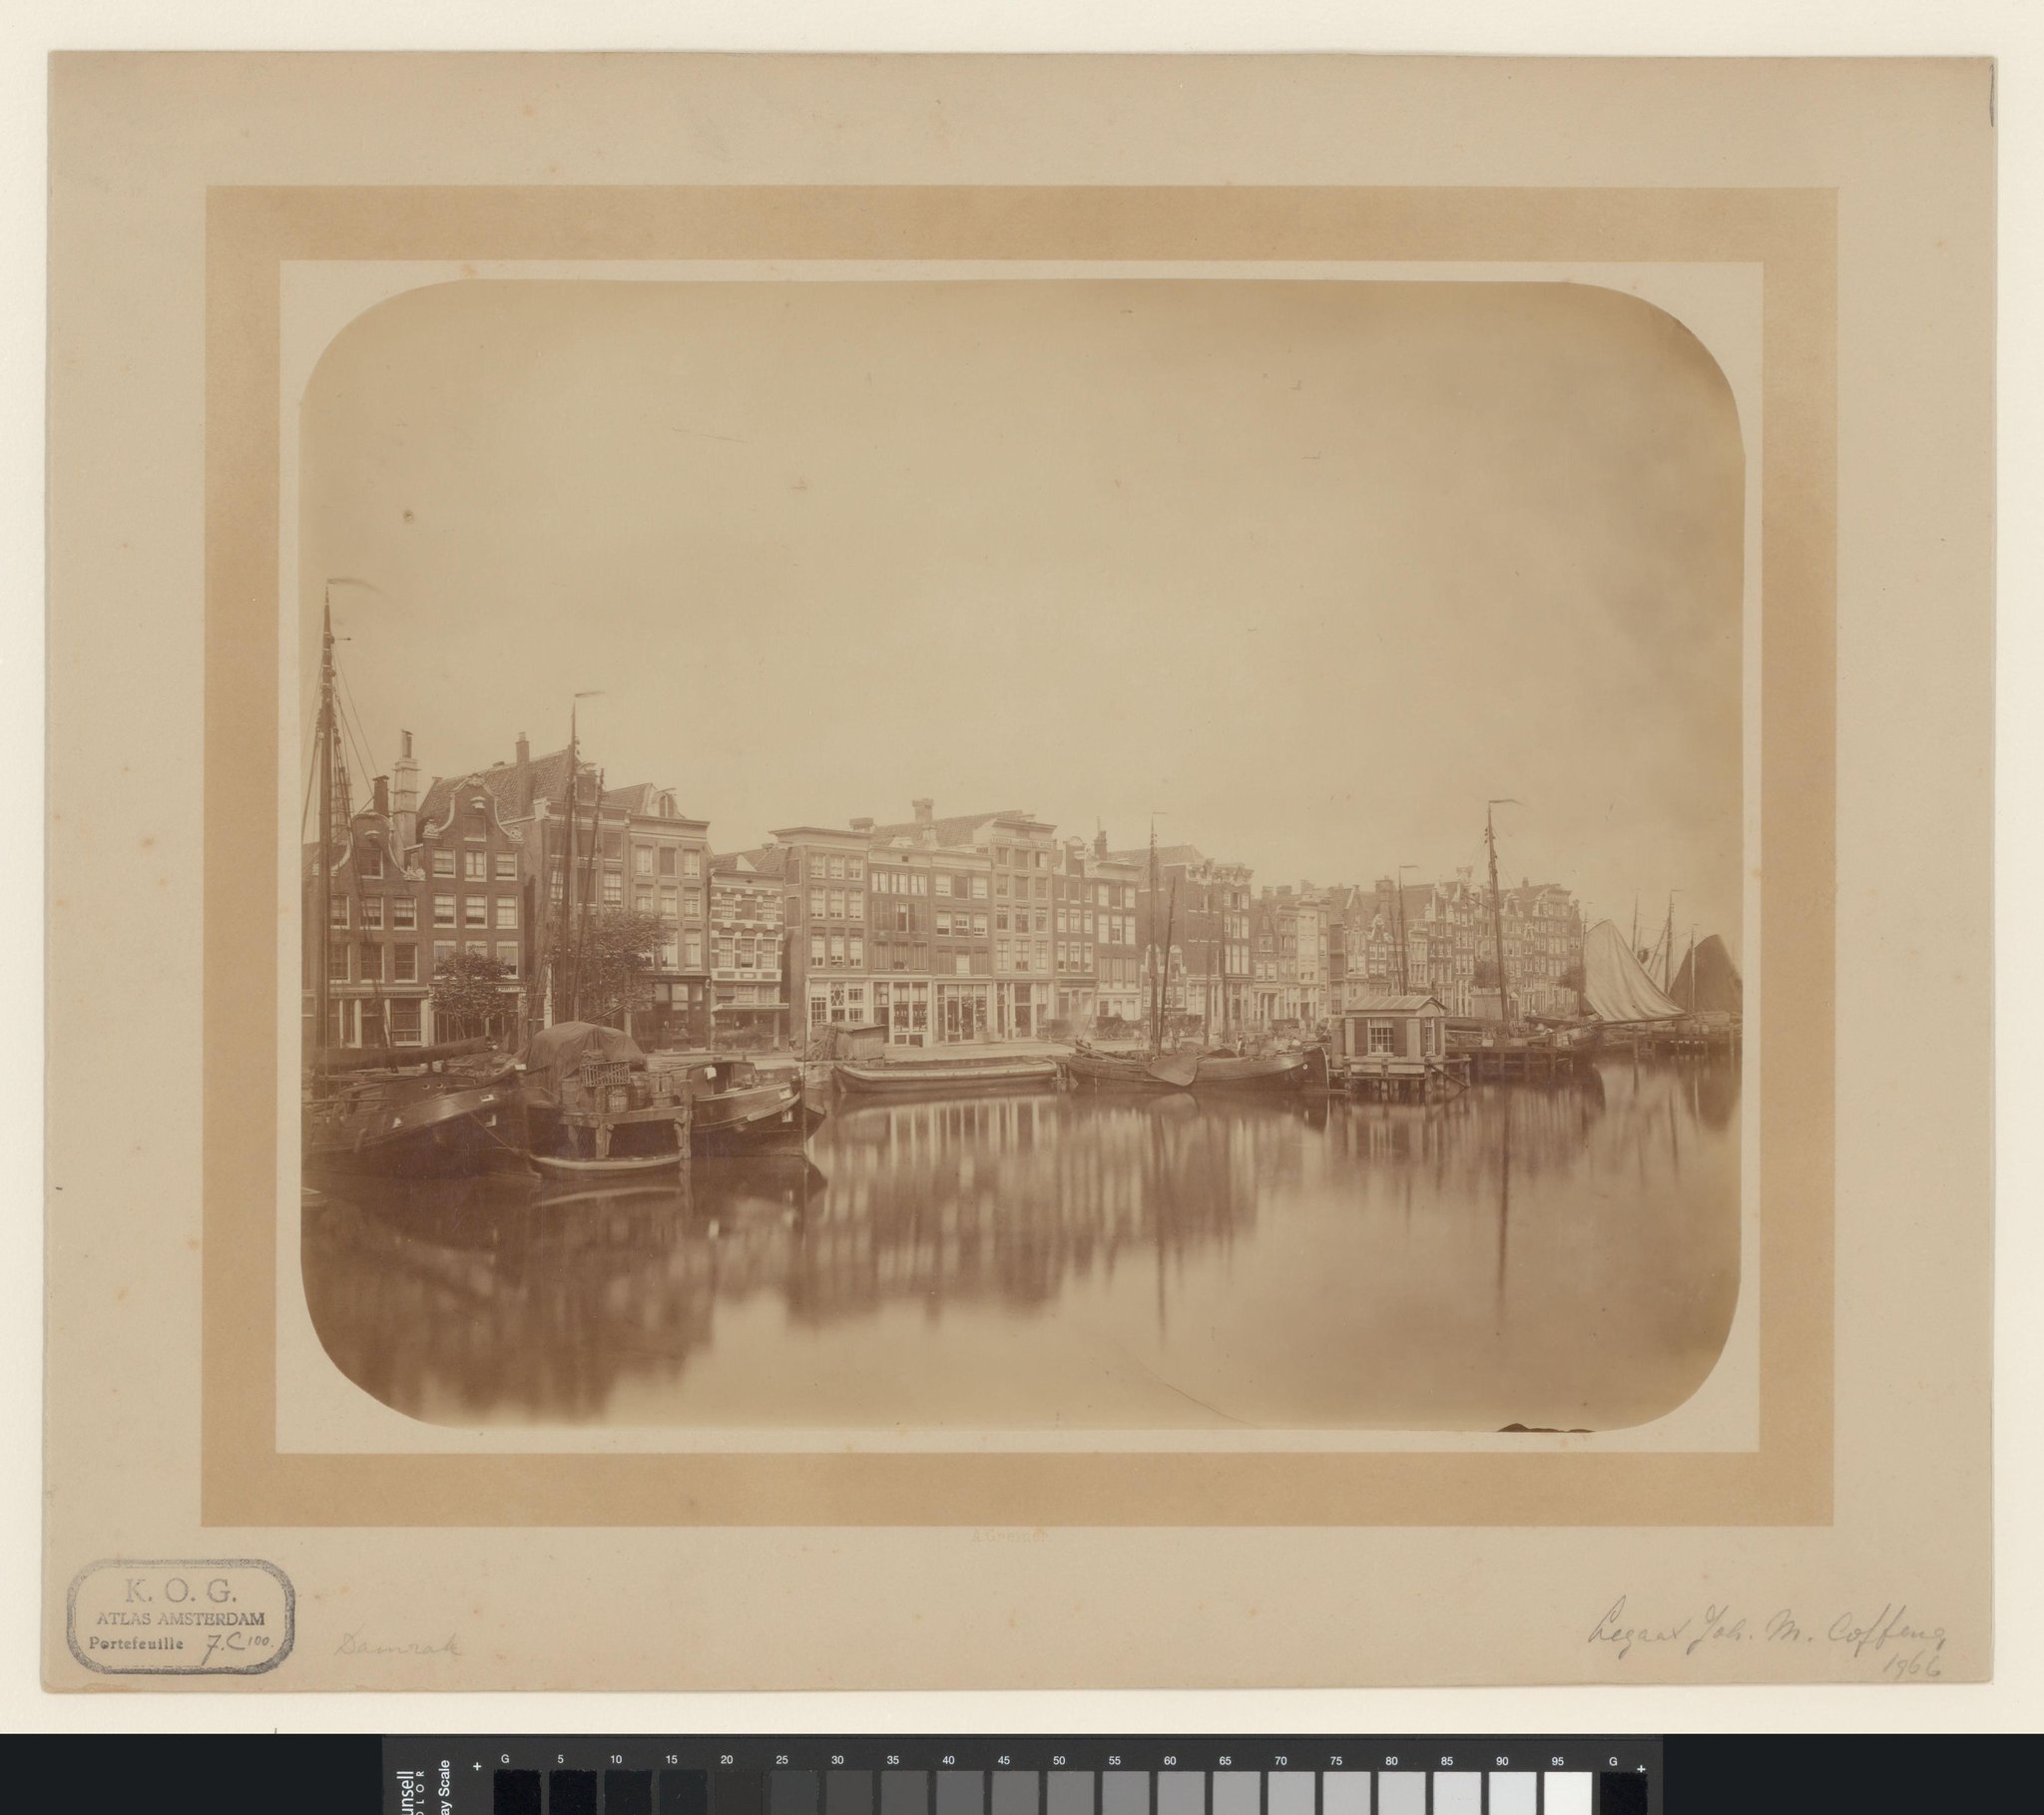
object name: photograph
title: Gezicht op het Damrak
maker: Anonymous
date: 1870-1915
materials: cardboard, paper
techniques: albumen print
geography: amsterdam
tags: city-view in general; 'veduta', canal, the usual house or row of houses, street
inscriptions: inscription: ‘Legaat Joh. M. Coffeng. 1966’, collector's mark: ‘7C’ Lugt 1641b, stamp: ‘Joh. M. Coffeng / Amsterdam’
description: Onderwerpsrubriek binnen de Atlas Amsterdam: Damrak, Damstraat, Doelensluis, Doelenstraat (Nieuwe), Driehoekstraat, Droogbak, Duvelshoek, Dijkstraat en Korte -.